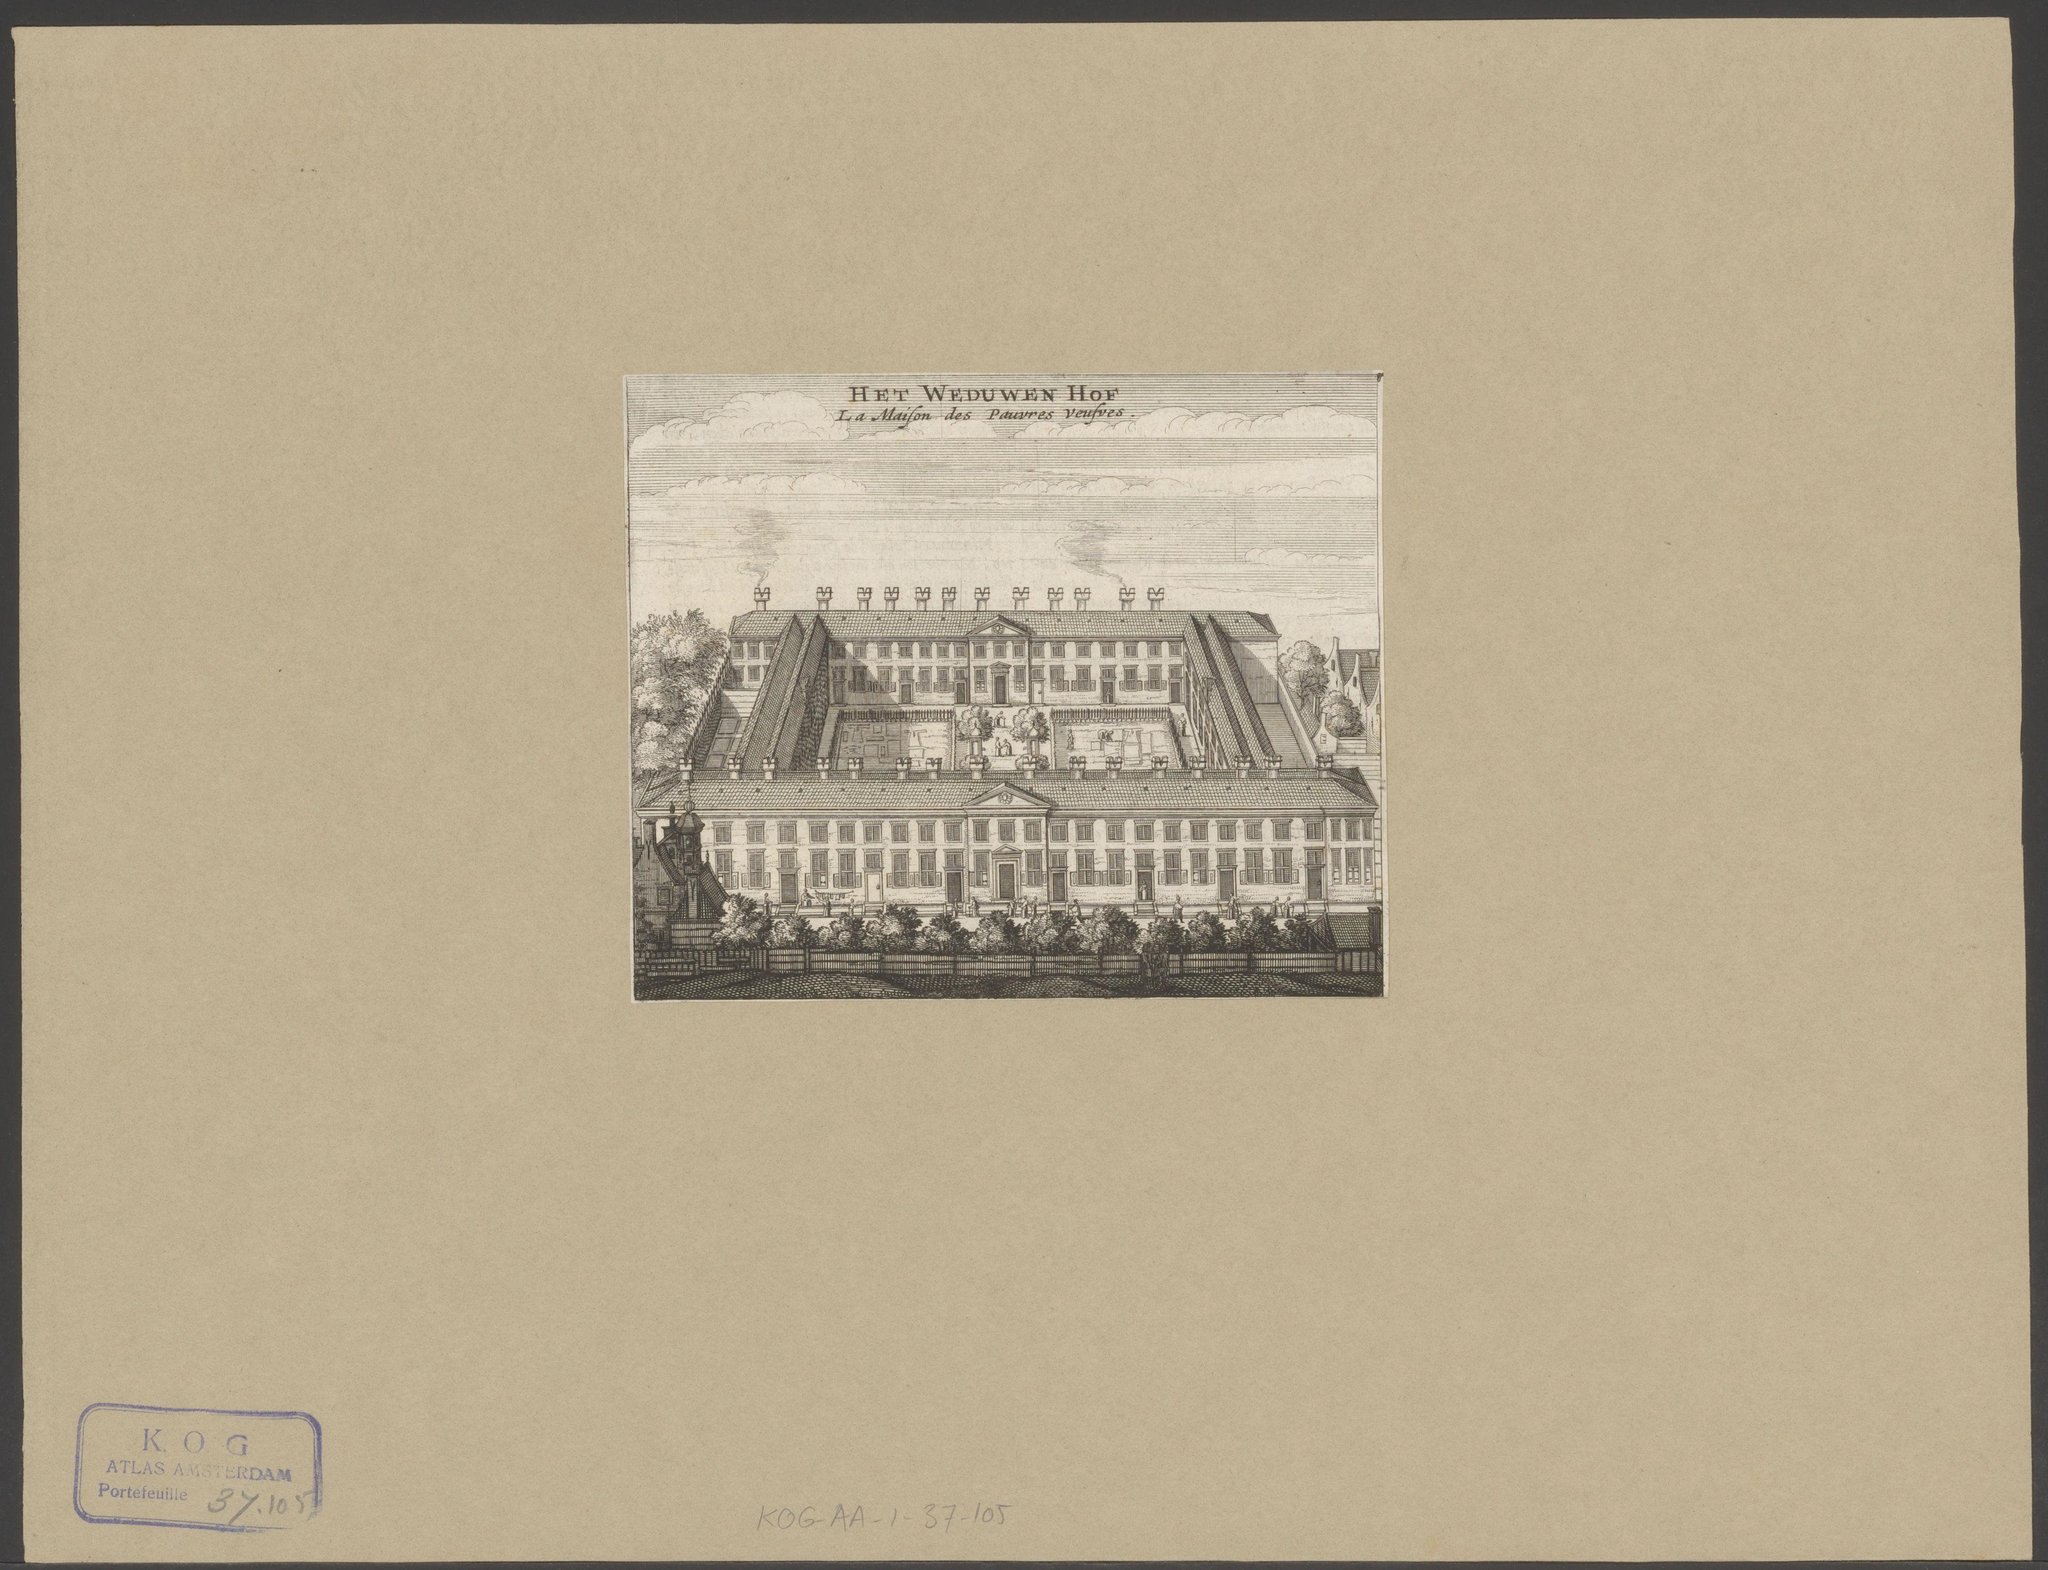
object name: book illustration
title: Het Weduwen Hof / La Maison des Pauvres Veufves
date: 1665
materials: paper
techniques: engraving, etching, letterpress printing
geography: amsterdam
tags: poorhouse, old-people's home, street (+ city(-scape) with figures, staffage)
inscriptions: collector's mark: Lugt 1641b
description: Onderwerpsrubriek binnen de Atlas Amsterdam: Armwezen en liefdadige instellingen: I. Stadsinrichtingen: Stedelijk Armenhuis - Huiszittenhuizen - Huiszitten Weduwenhof.